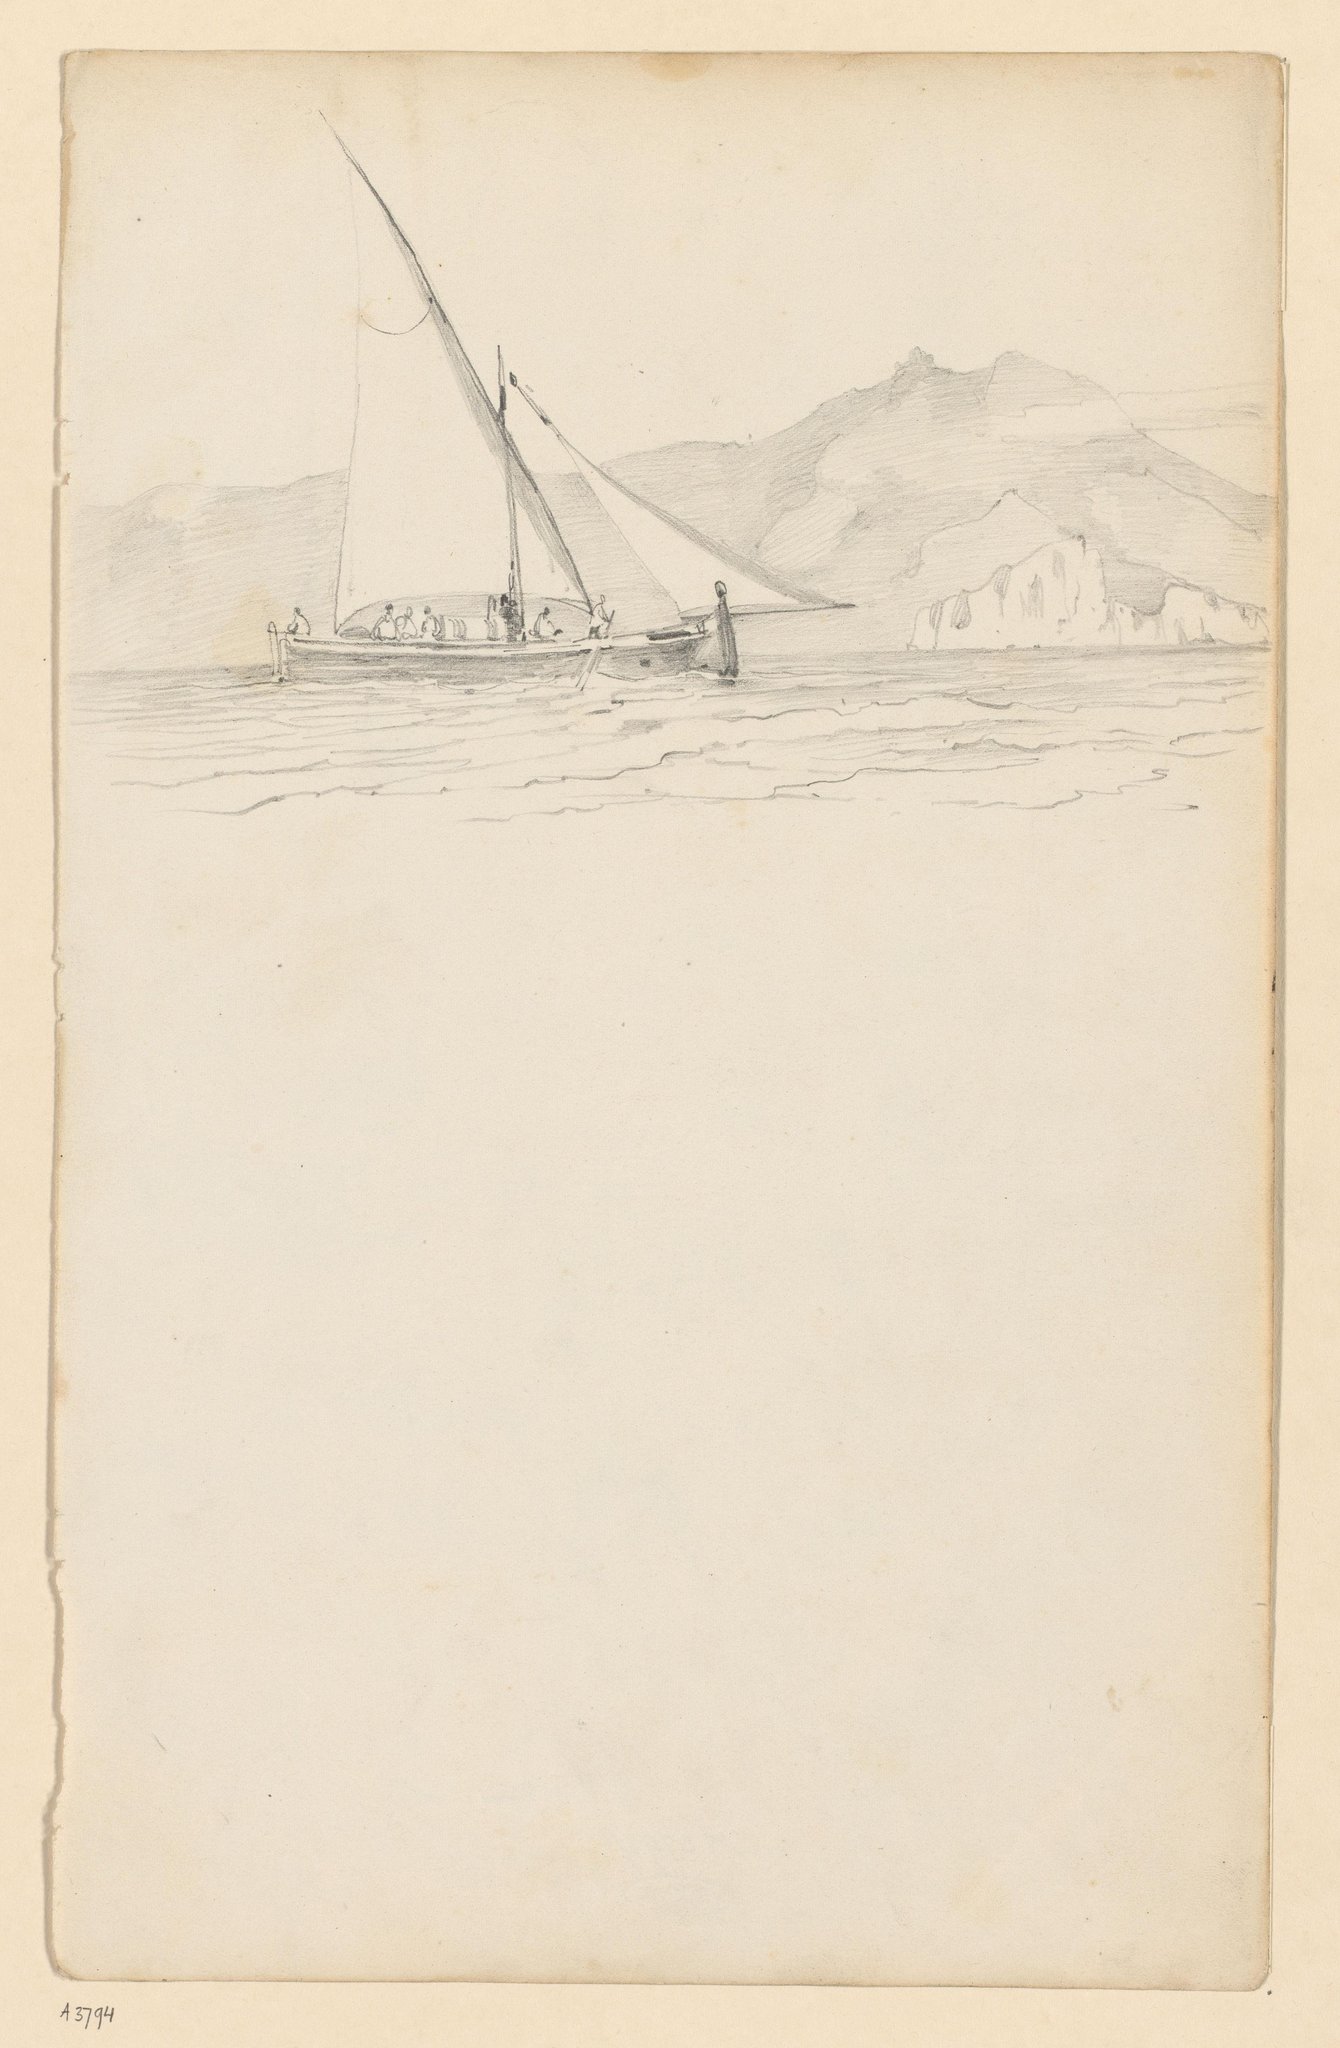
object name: drawing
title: Een zeilschip voor de kust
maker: willem anthonie van deventer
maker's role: draughtsman, painter, print maker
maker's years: 1824-1893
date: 1834-1893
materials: paper, pencil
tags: sailing-ship, sailing-boat